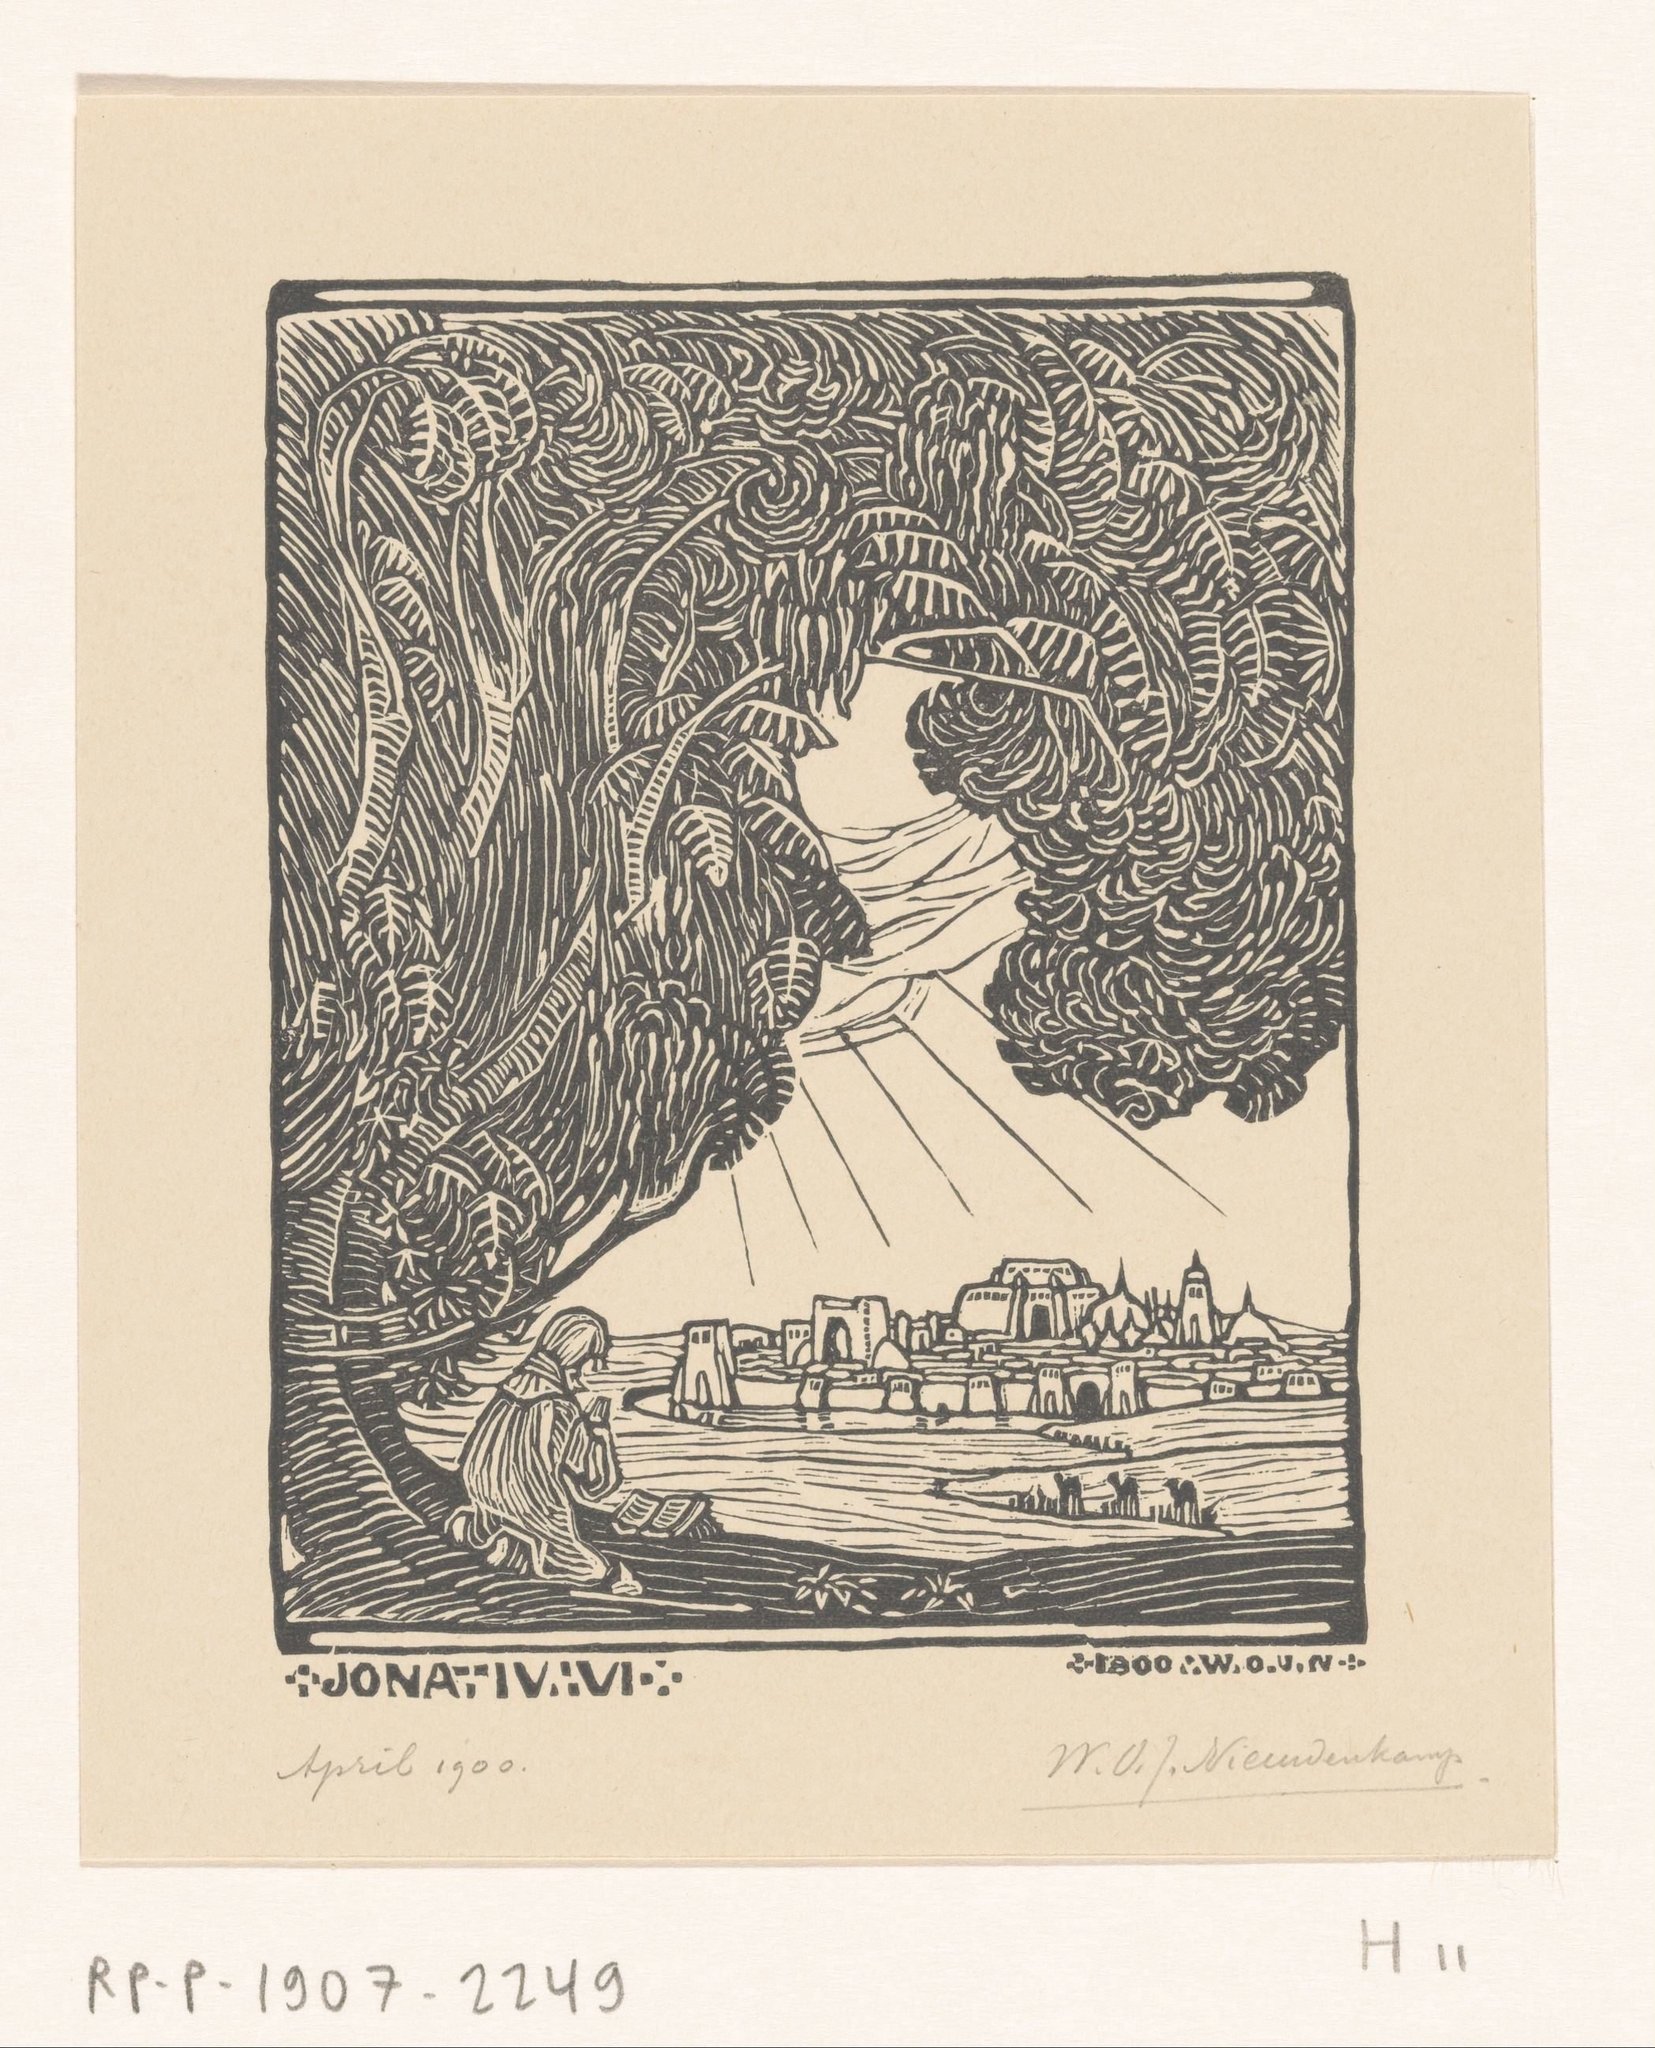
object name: print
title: Jona zit onder de wonderboom in de buurt van Nineve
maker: wijnand otto jan nieuwenkamp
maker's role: draughtsman, print maker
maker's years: 1874-1950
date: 1900-1904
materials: paper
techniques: woodcut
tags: the prophet jonah withdraws from nineveh; he builds a booth and while enjoying the shade of a plant (gourd or vine) which god made grow for him, he awaits the destiny of the city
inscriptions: collector's mark: Lugt 2228